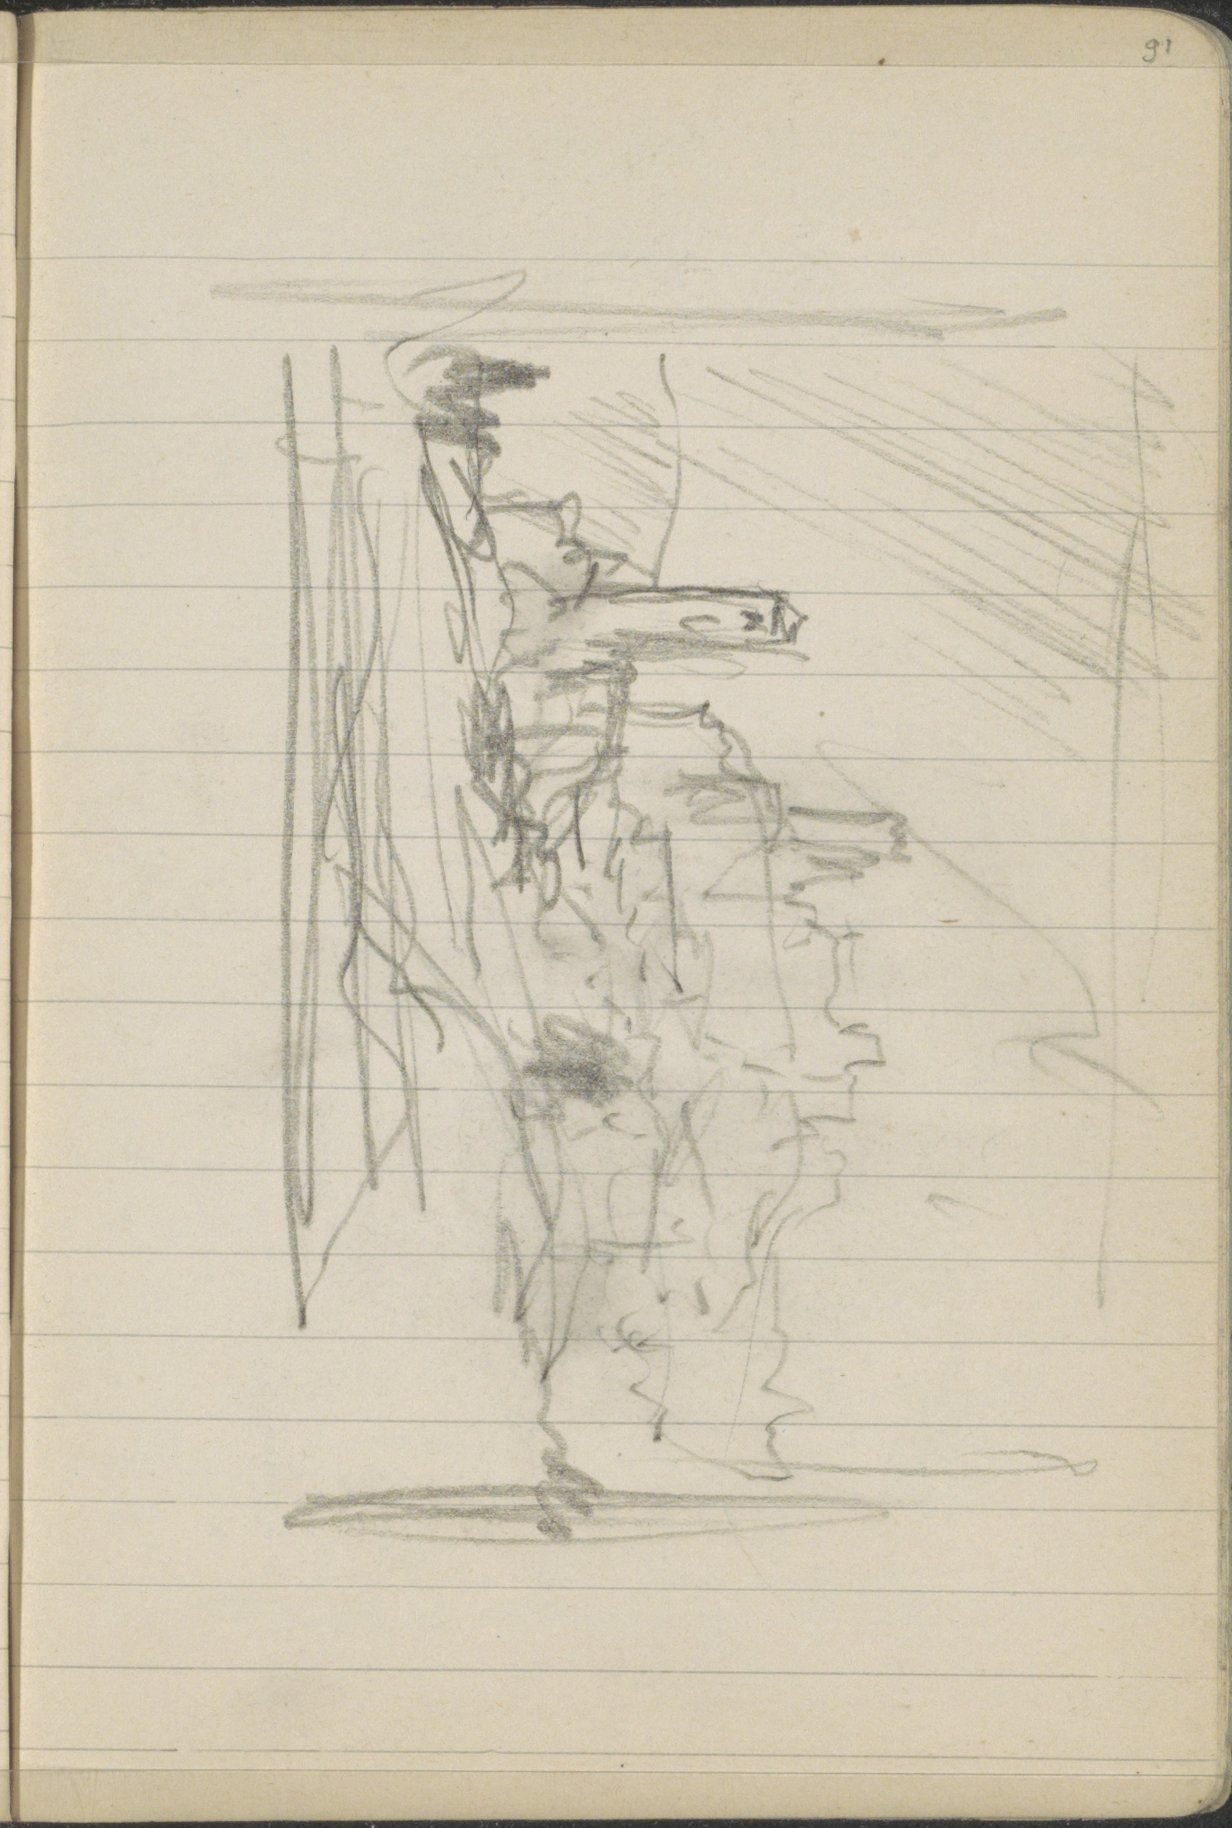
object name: sketchbook leaf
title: Gebouw, mogelijk een kasteel, in een heuvellandschap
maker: marius bauer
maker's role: draughtsman, print maker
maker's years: 1867-1932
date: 1902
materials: pencil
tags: landscape with tower or castle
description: Pagina 91 uit een schetsboek met 50 bladen.